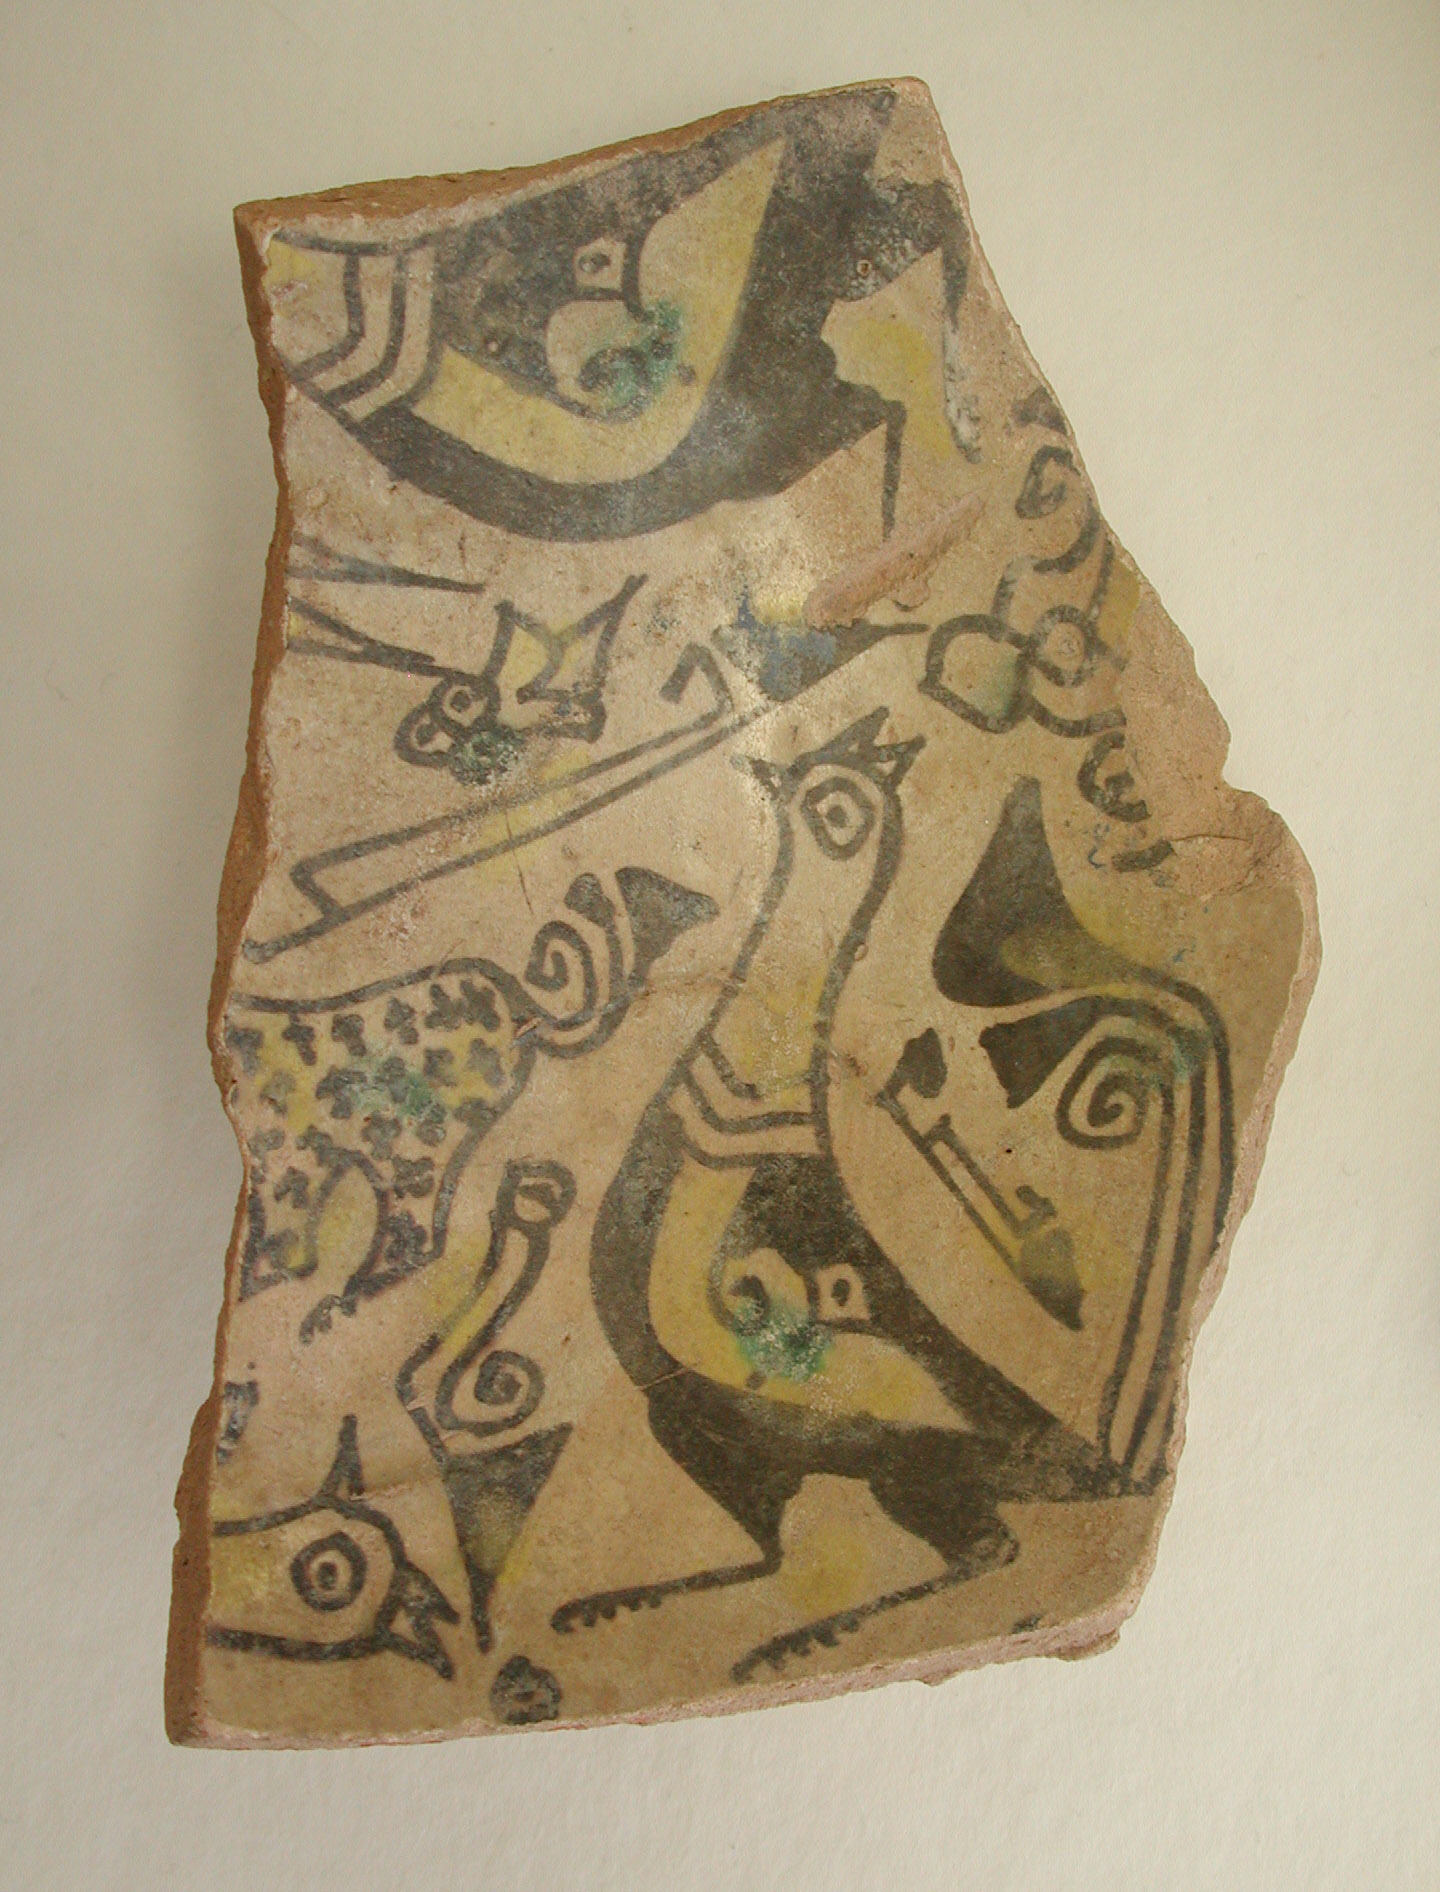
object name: fragment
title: Fragment of a Bowl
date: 801-1000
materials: earthenware, glaze, pigment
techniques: painting, polychrome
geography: iran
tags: birds